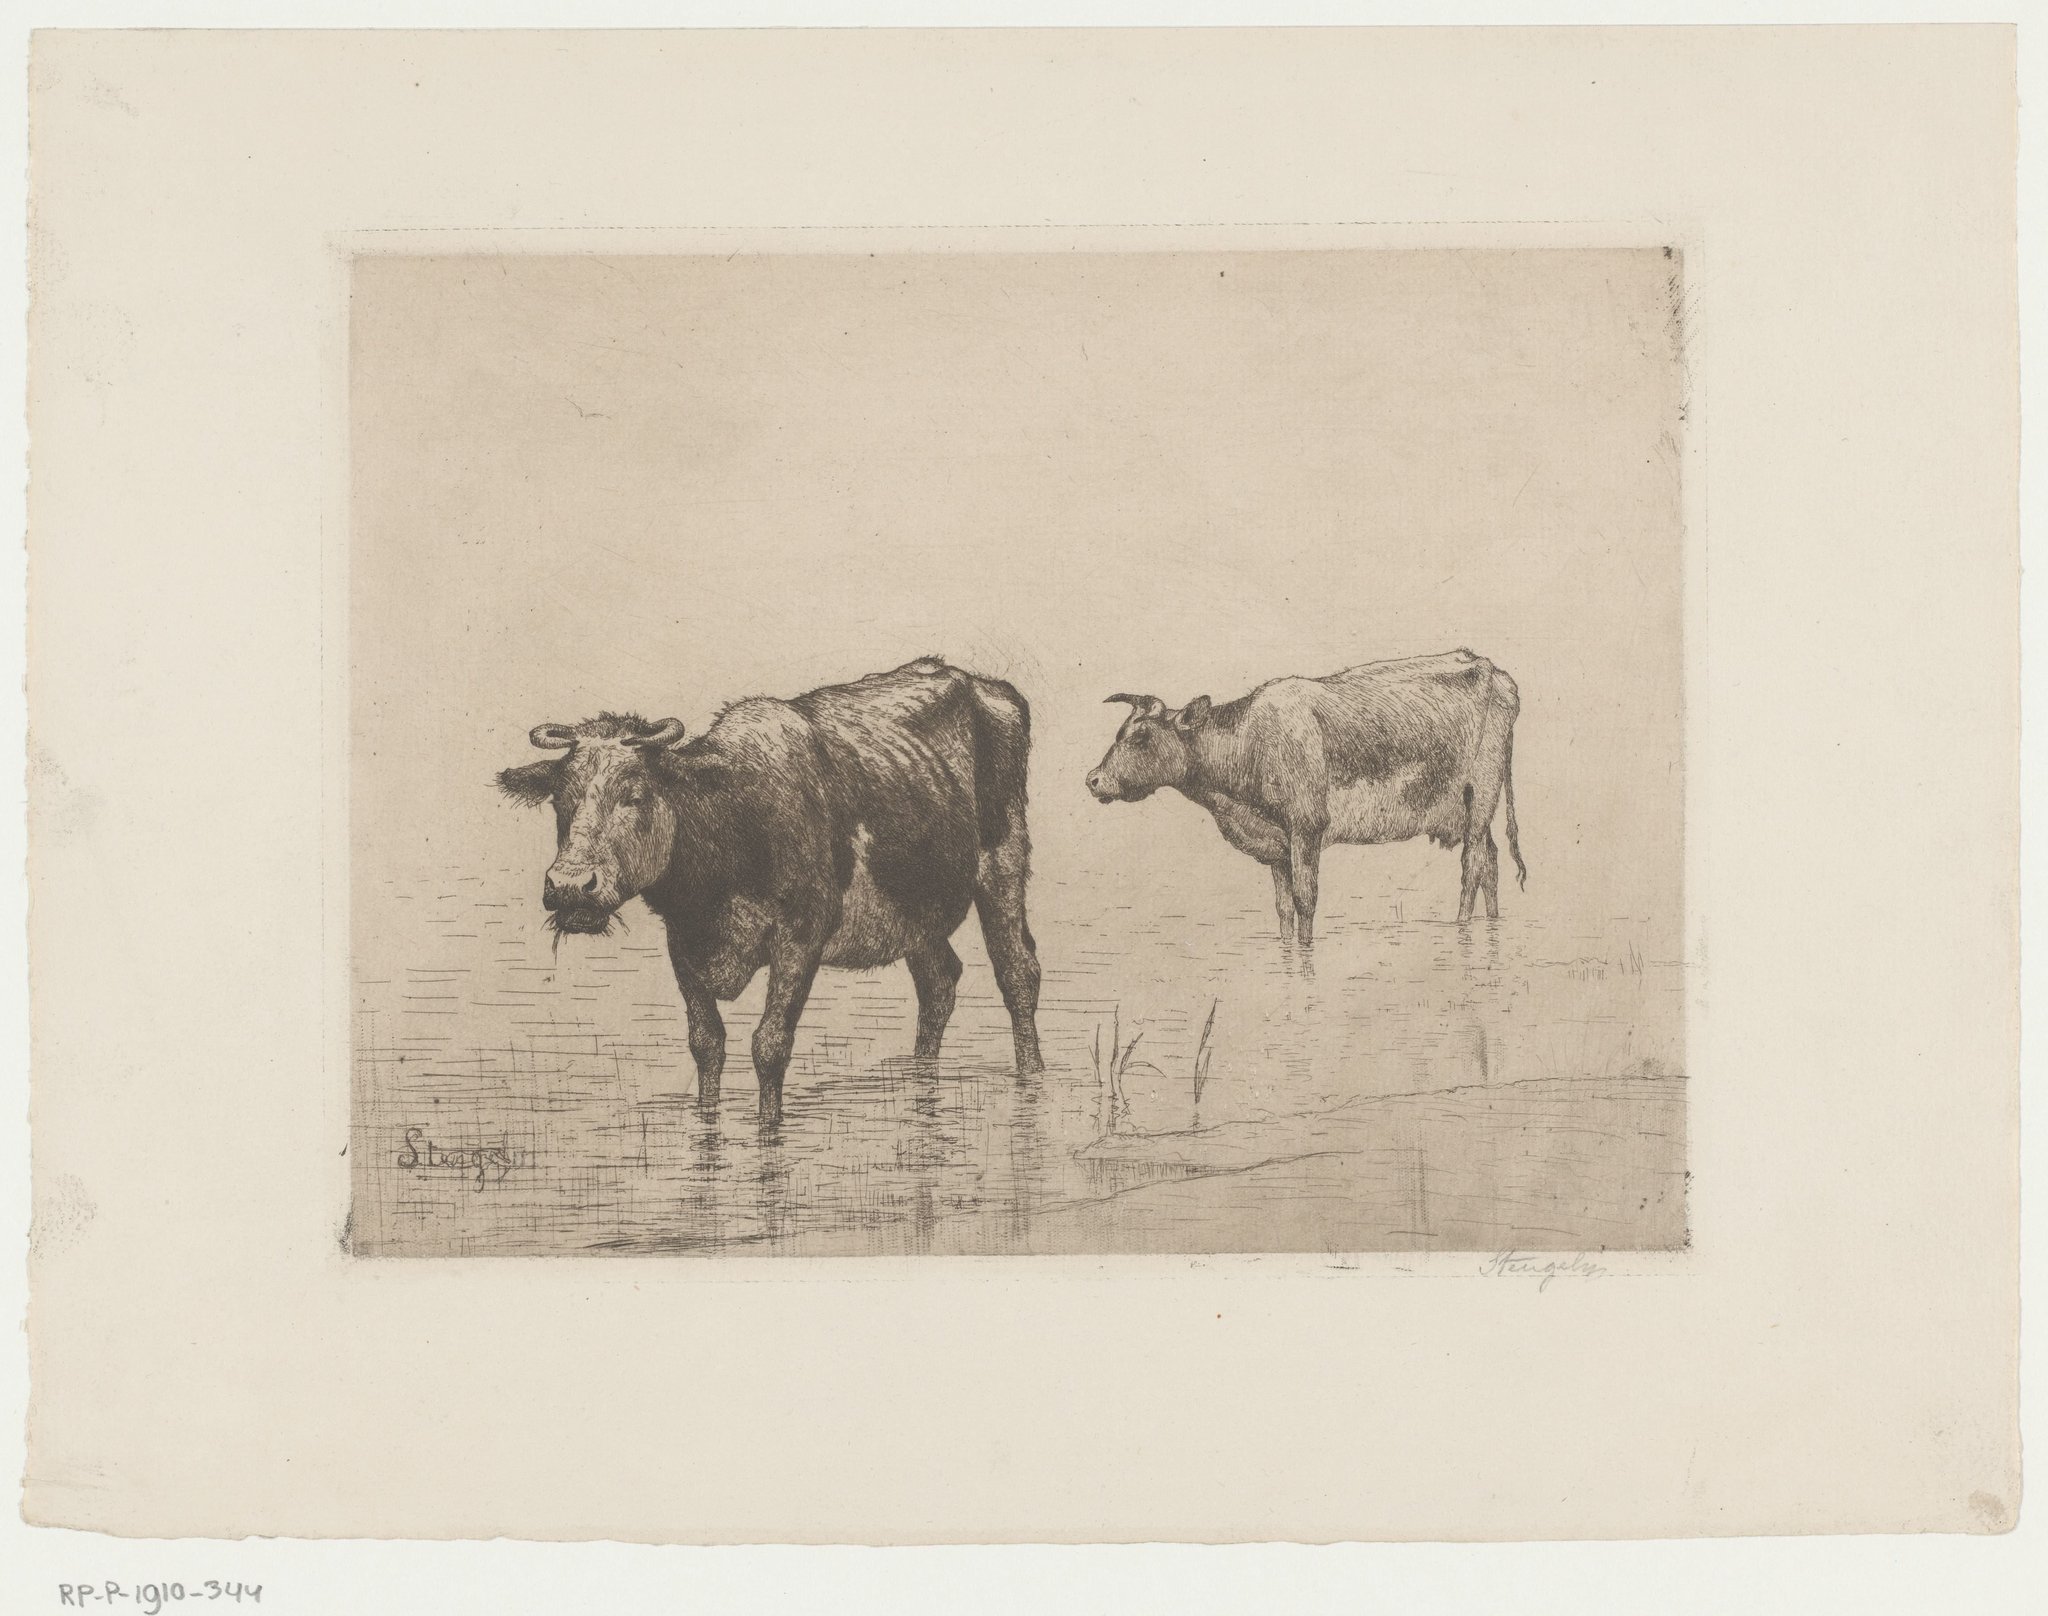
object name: print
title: Twee koeien in een plas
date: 1862-1910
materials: paper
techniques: etching, intaglio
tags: cow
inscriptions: watermark, collector's mark: Lugt 2228